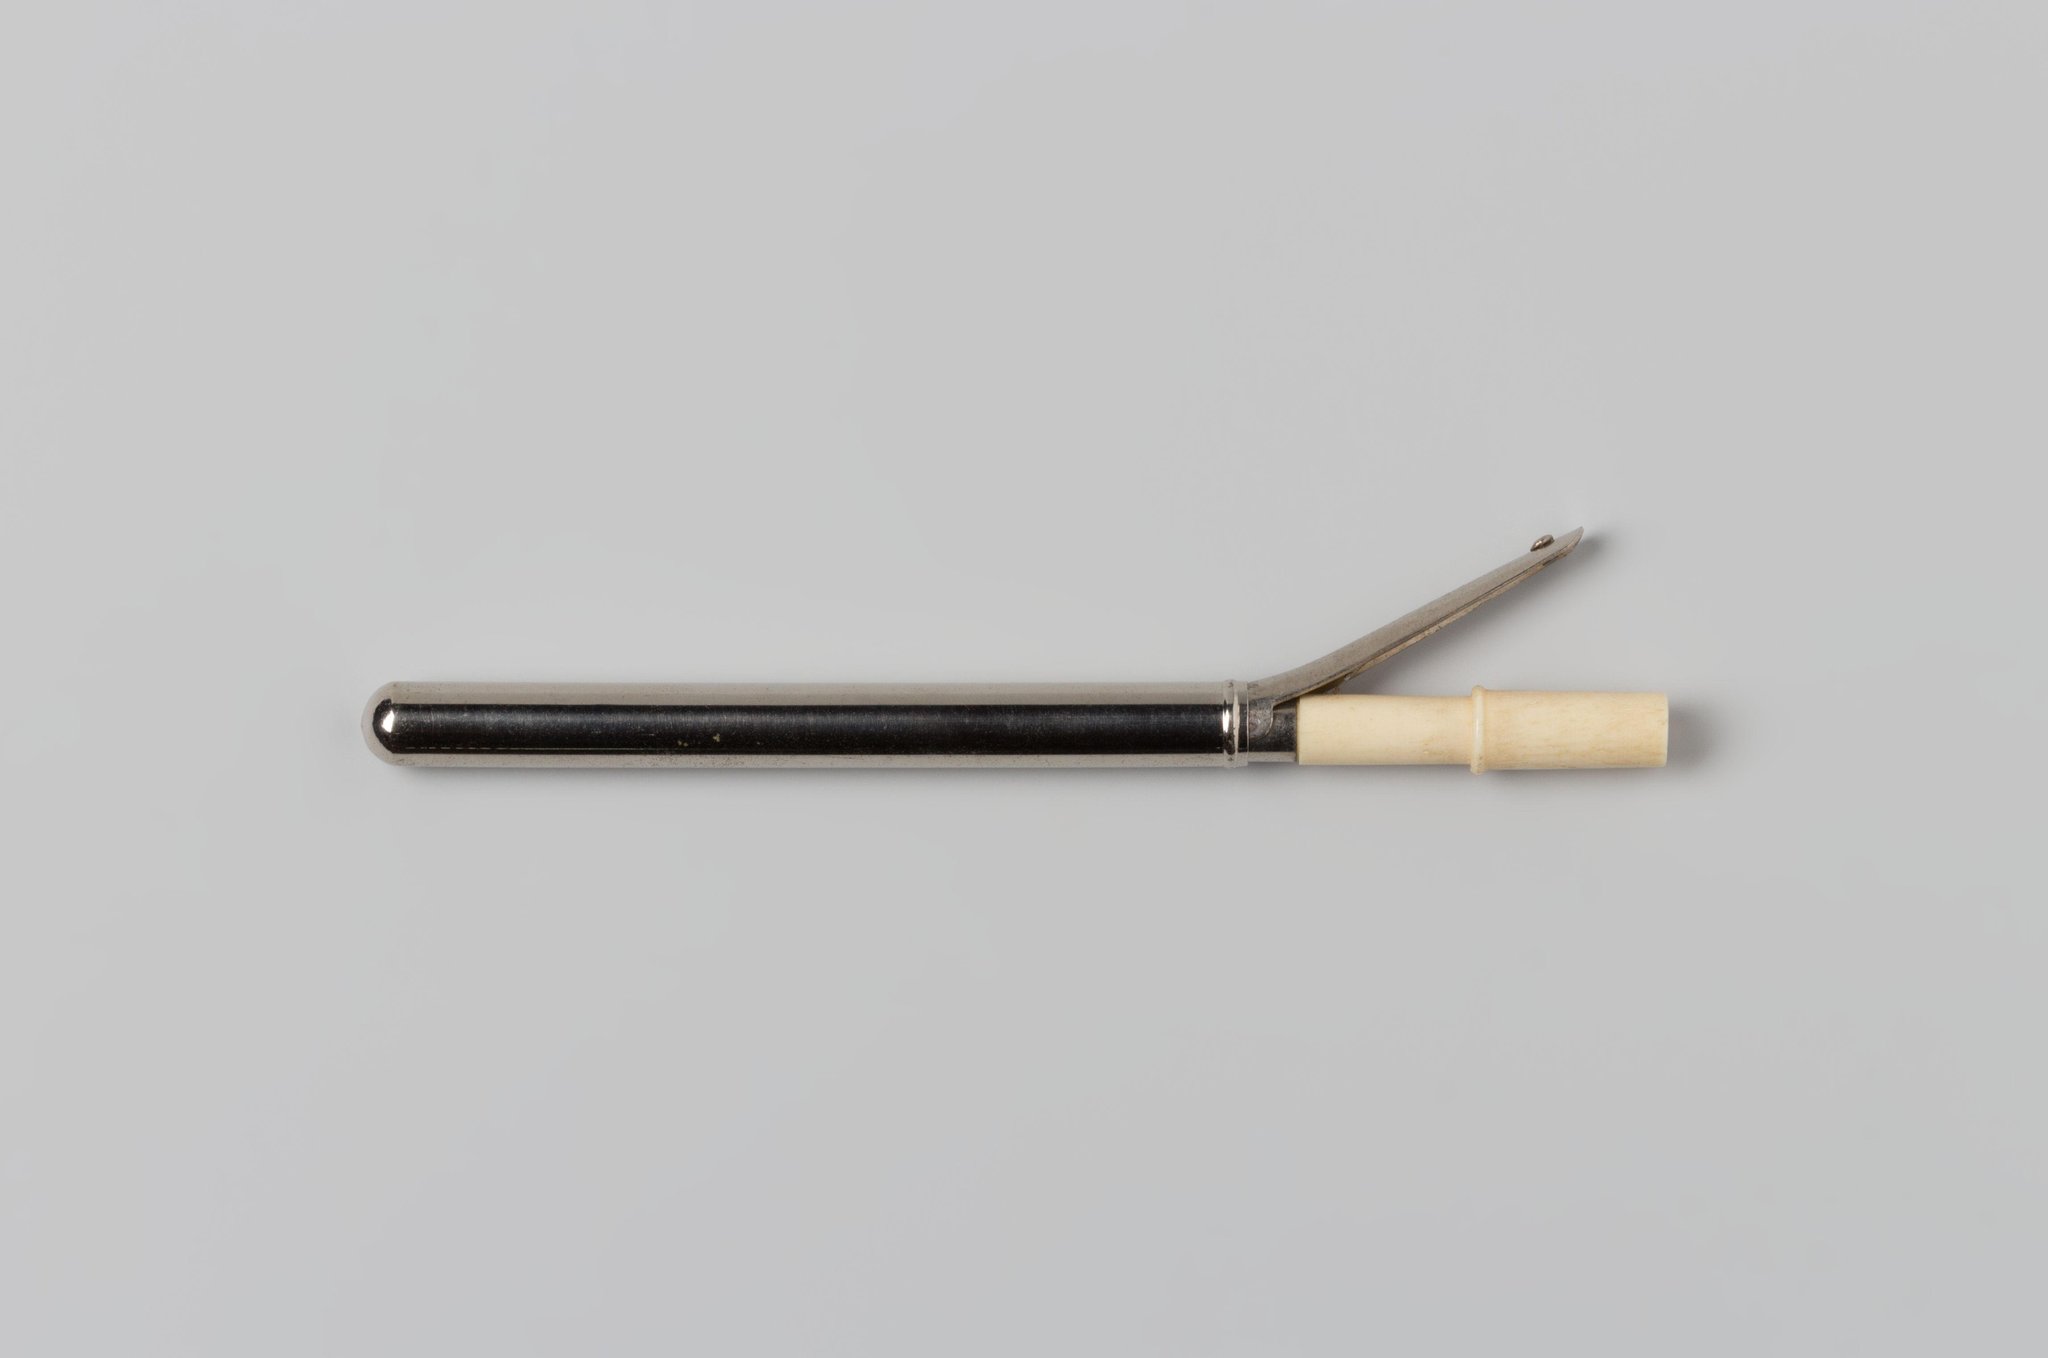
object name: friseertang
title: Friseertang van staal met handvat van been, in cylindrische koker van staal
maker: Anonymous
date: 1915-1935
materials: bone, steel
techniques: cutting, forging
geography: paris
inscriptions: company name: ‘'G.B.BREVETÉ.S.G.D.G'’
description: Friseertangetje voor de handtas, in wit doosje. Cylindrisch, van een dik staafje en een daarop passende gehalveerde cylinder.